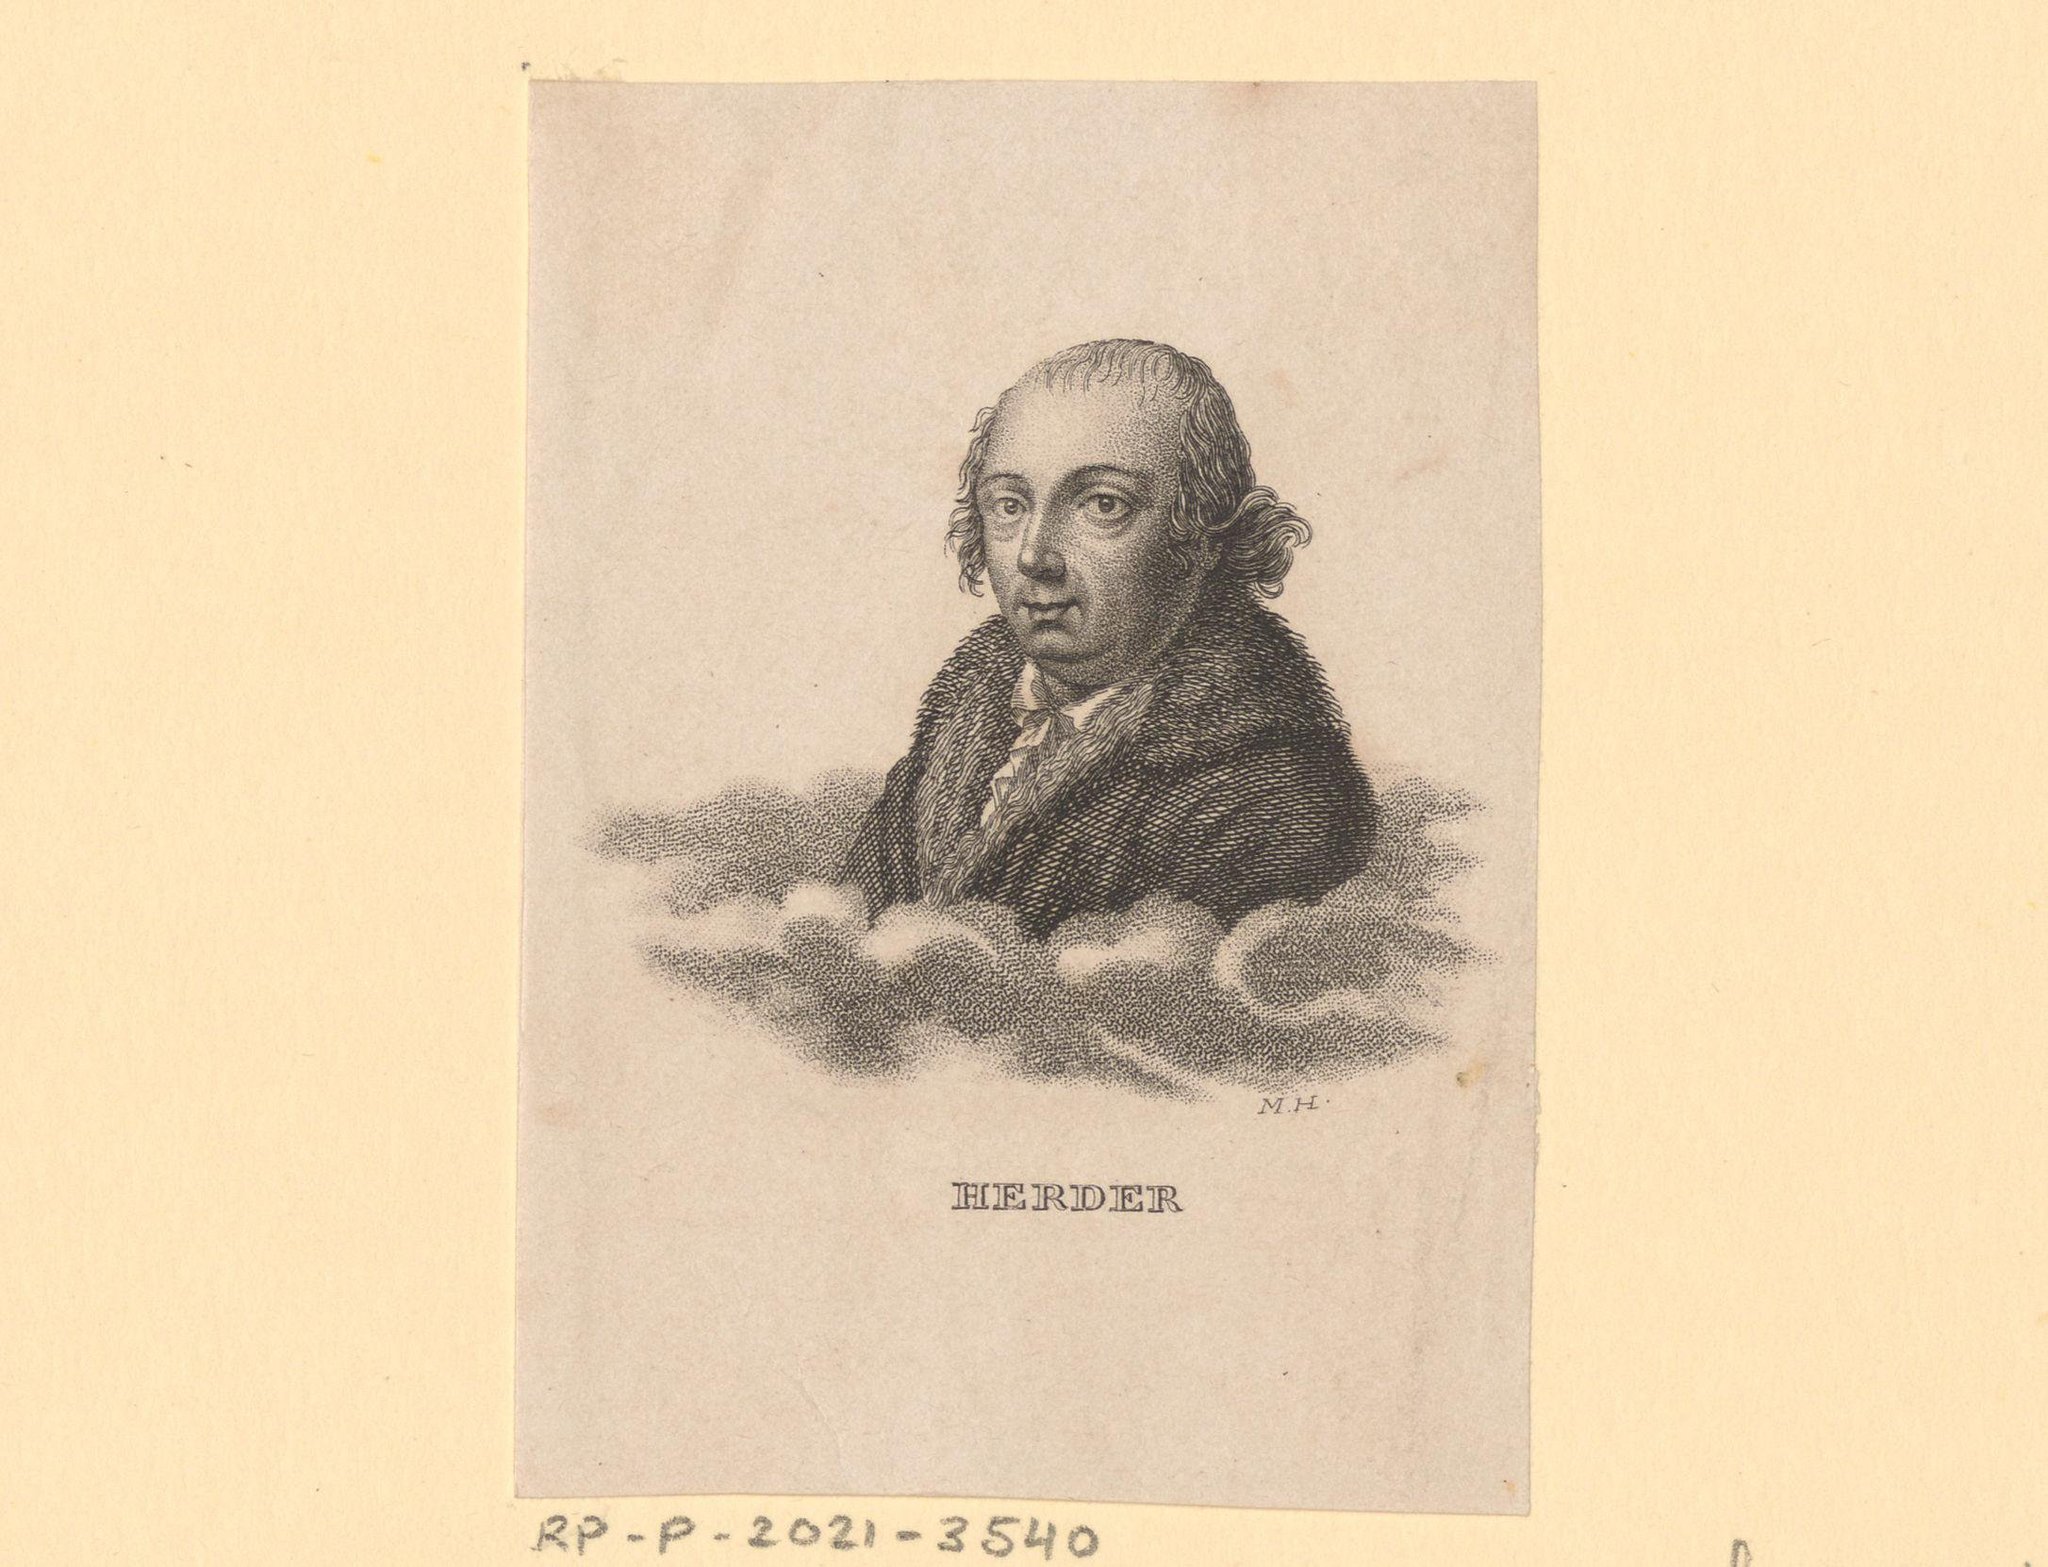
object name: print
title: Portret van Johann Gottfried von Herder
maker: Anonymous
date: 1800-1849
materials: paper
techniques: etching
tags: historical persons, writer, poet, author